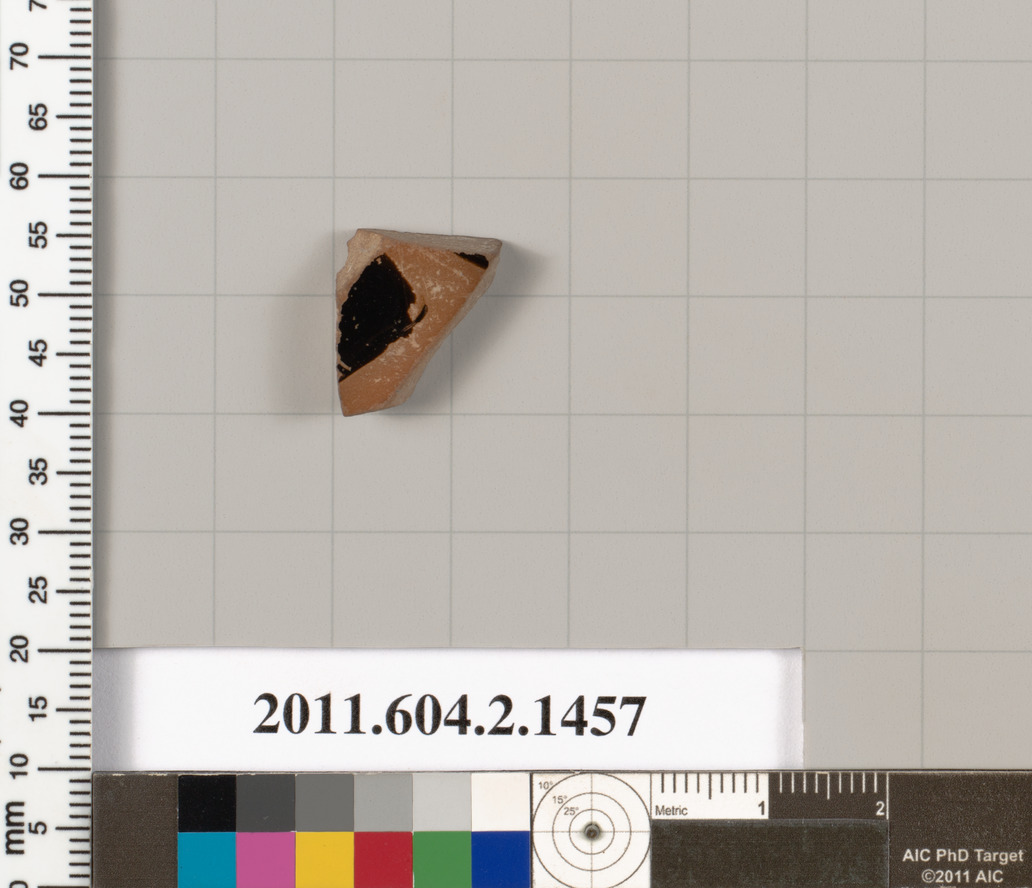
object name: skyphos fragment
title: Terracotta fragment of a skyphos (deep drinking cup)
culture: greek, attic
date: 460-440 BCE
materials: terracotta